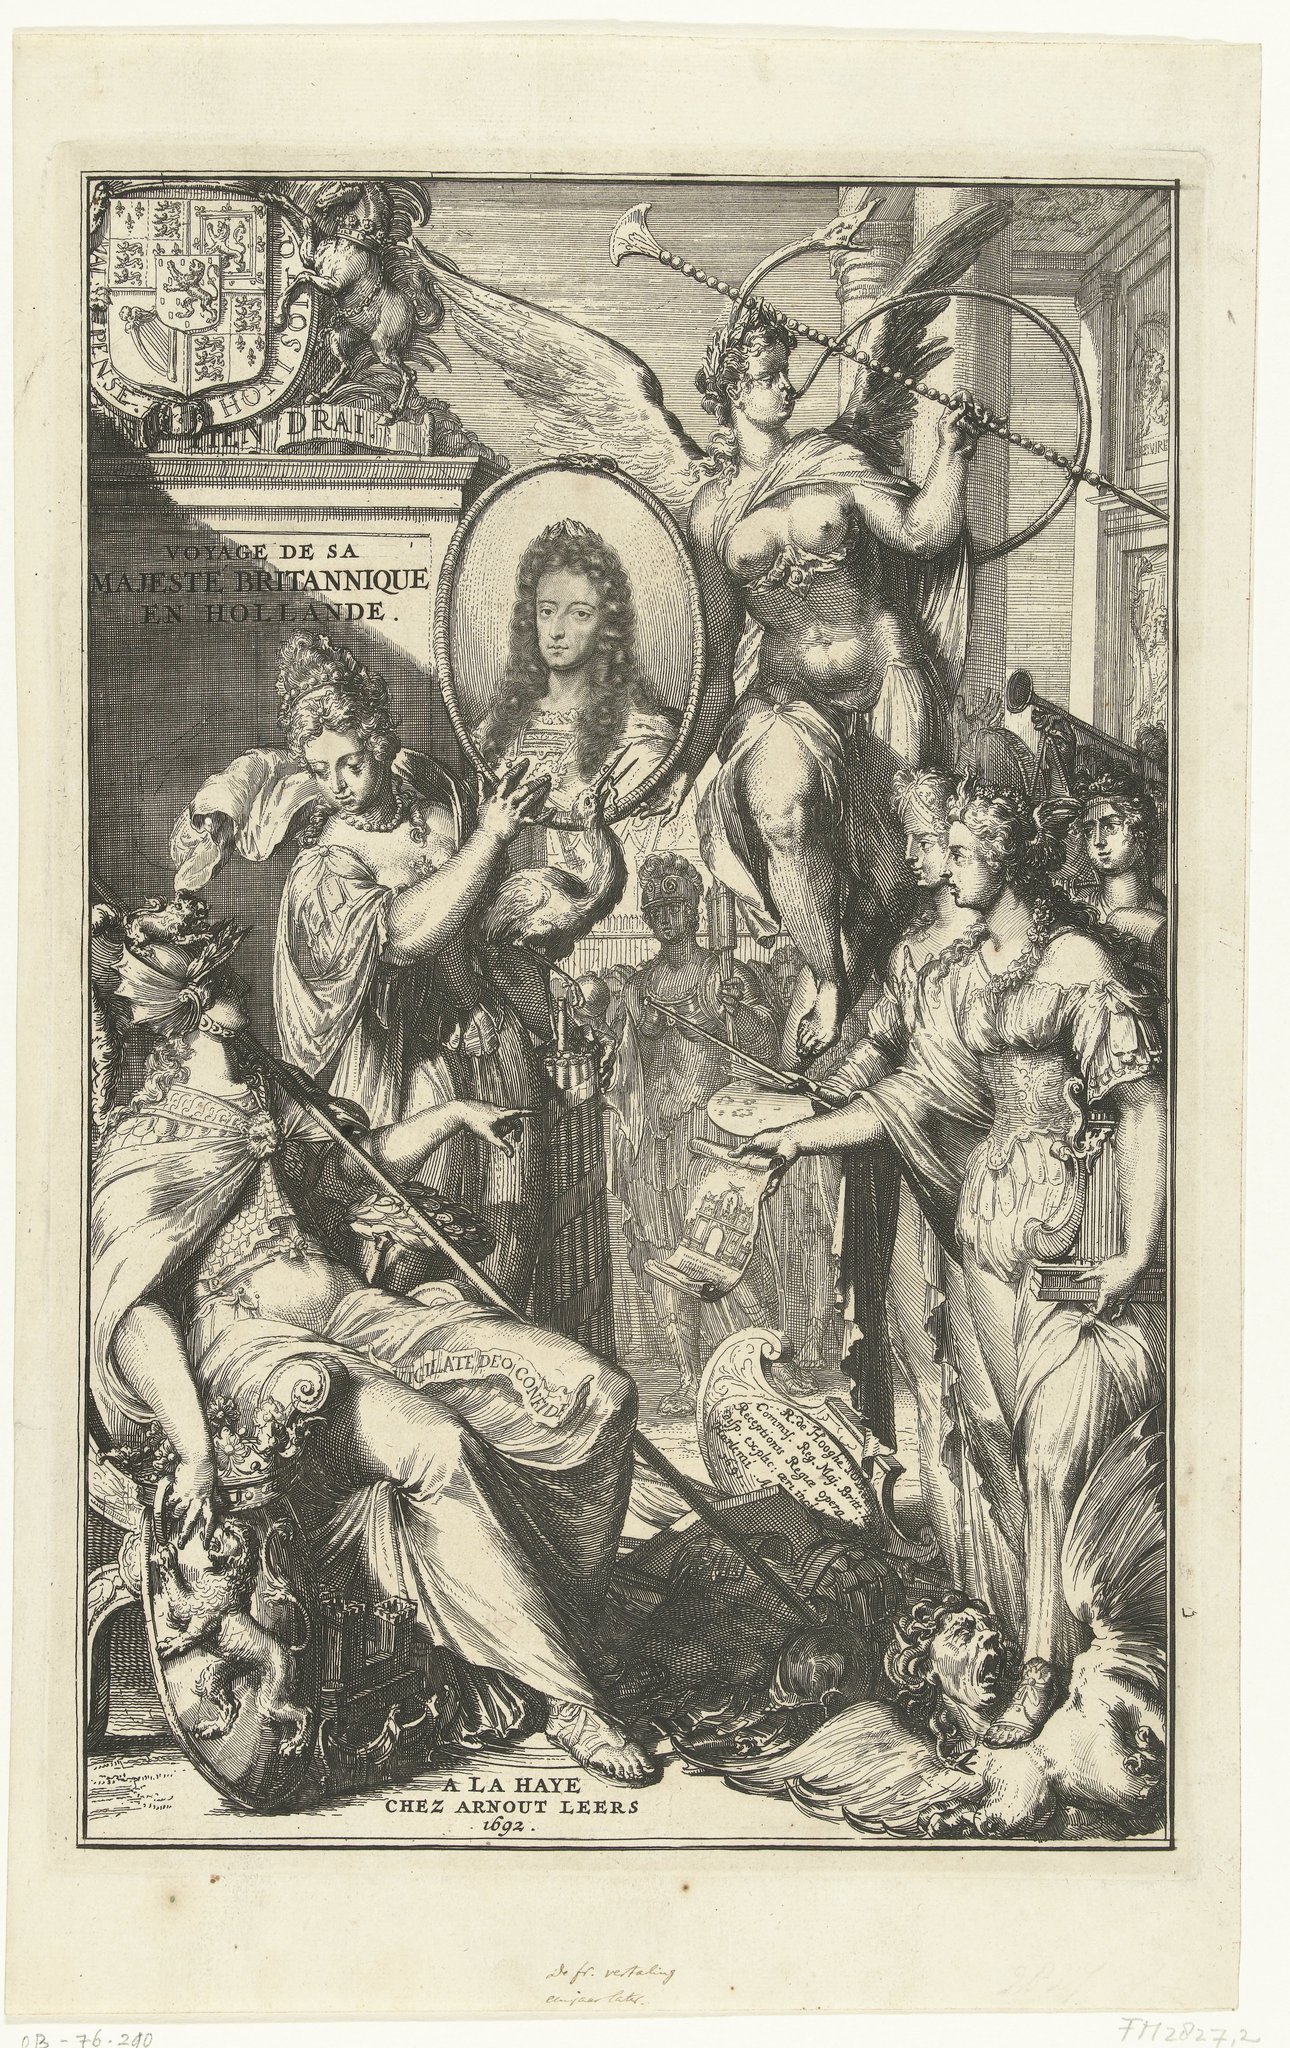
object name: titelprent, frontispice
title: Allegorische frontispice met portret van Willem III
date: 1691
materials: paper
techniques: etching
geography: the hague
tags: the hague, william iii (prince of orange and king of england, scotland, and ireland), 'pictura', symbolic representations, allegories and emblems ~ painting; 'pittura' (ripa), personifications of countries, nations, states, districts, etc., 'architectura', symbolic representations, allegories and emblems ~ architecture; 'architettura' (ripa), fame; 'fama', 'fama buona', 'fama chiara' (ripa), netherlands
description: Illustratie voor: Relation du voyage de sa majesté Britannique en Hollande, et de la réception qui luy a été faite, enr. de planches très-curieuses. Avec un récit abrégé de ce qui s'est passé de plus considérable depuis l'arrivée de Sa Majestée en Hollande le 31. de janvier, jusqu'à son retour en Angleterre, au mois d'avril 1691, et l'heureux succès de l'expédition d'Irlande, Arnout Leers, Den Haag 1692.